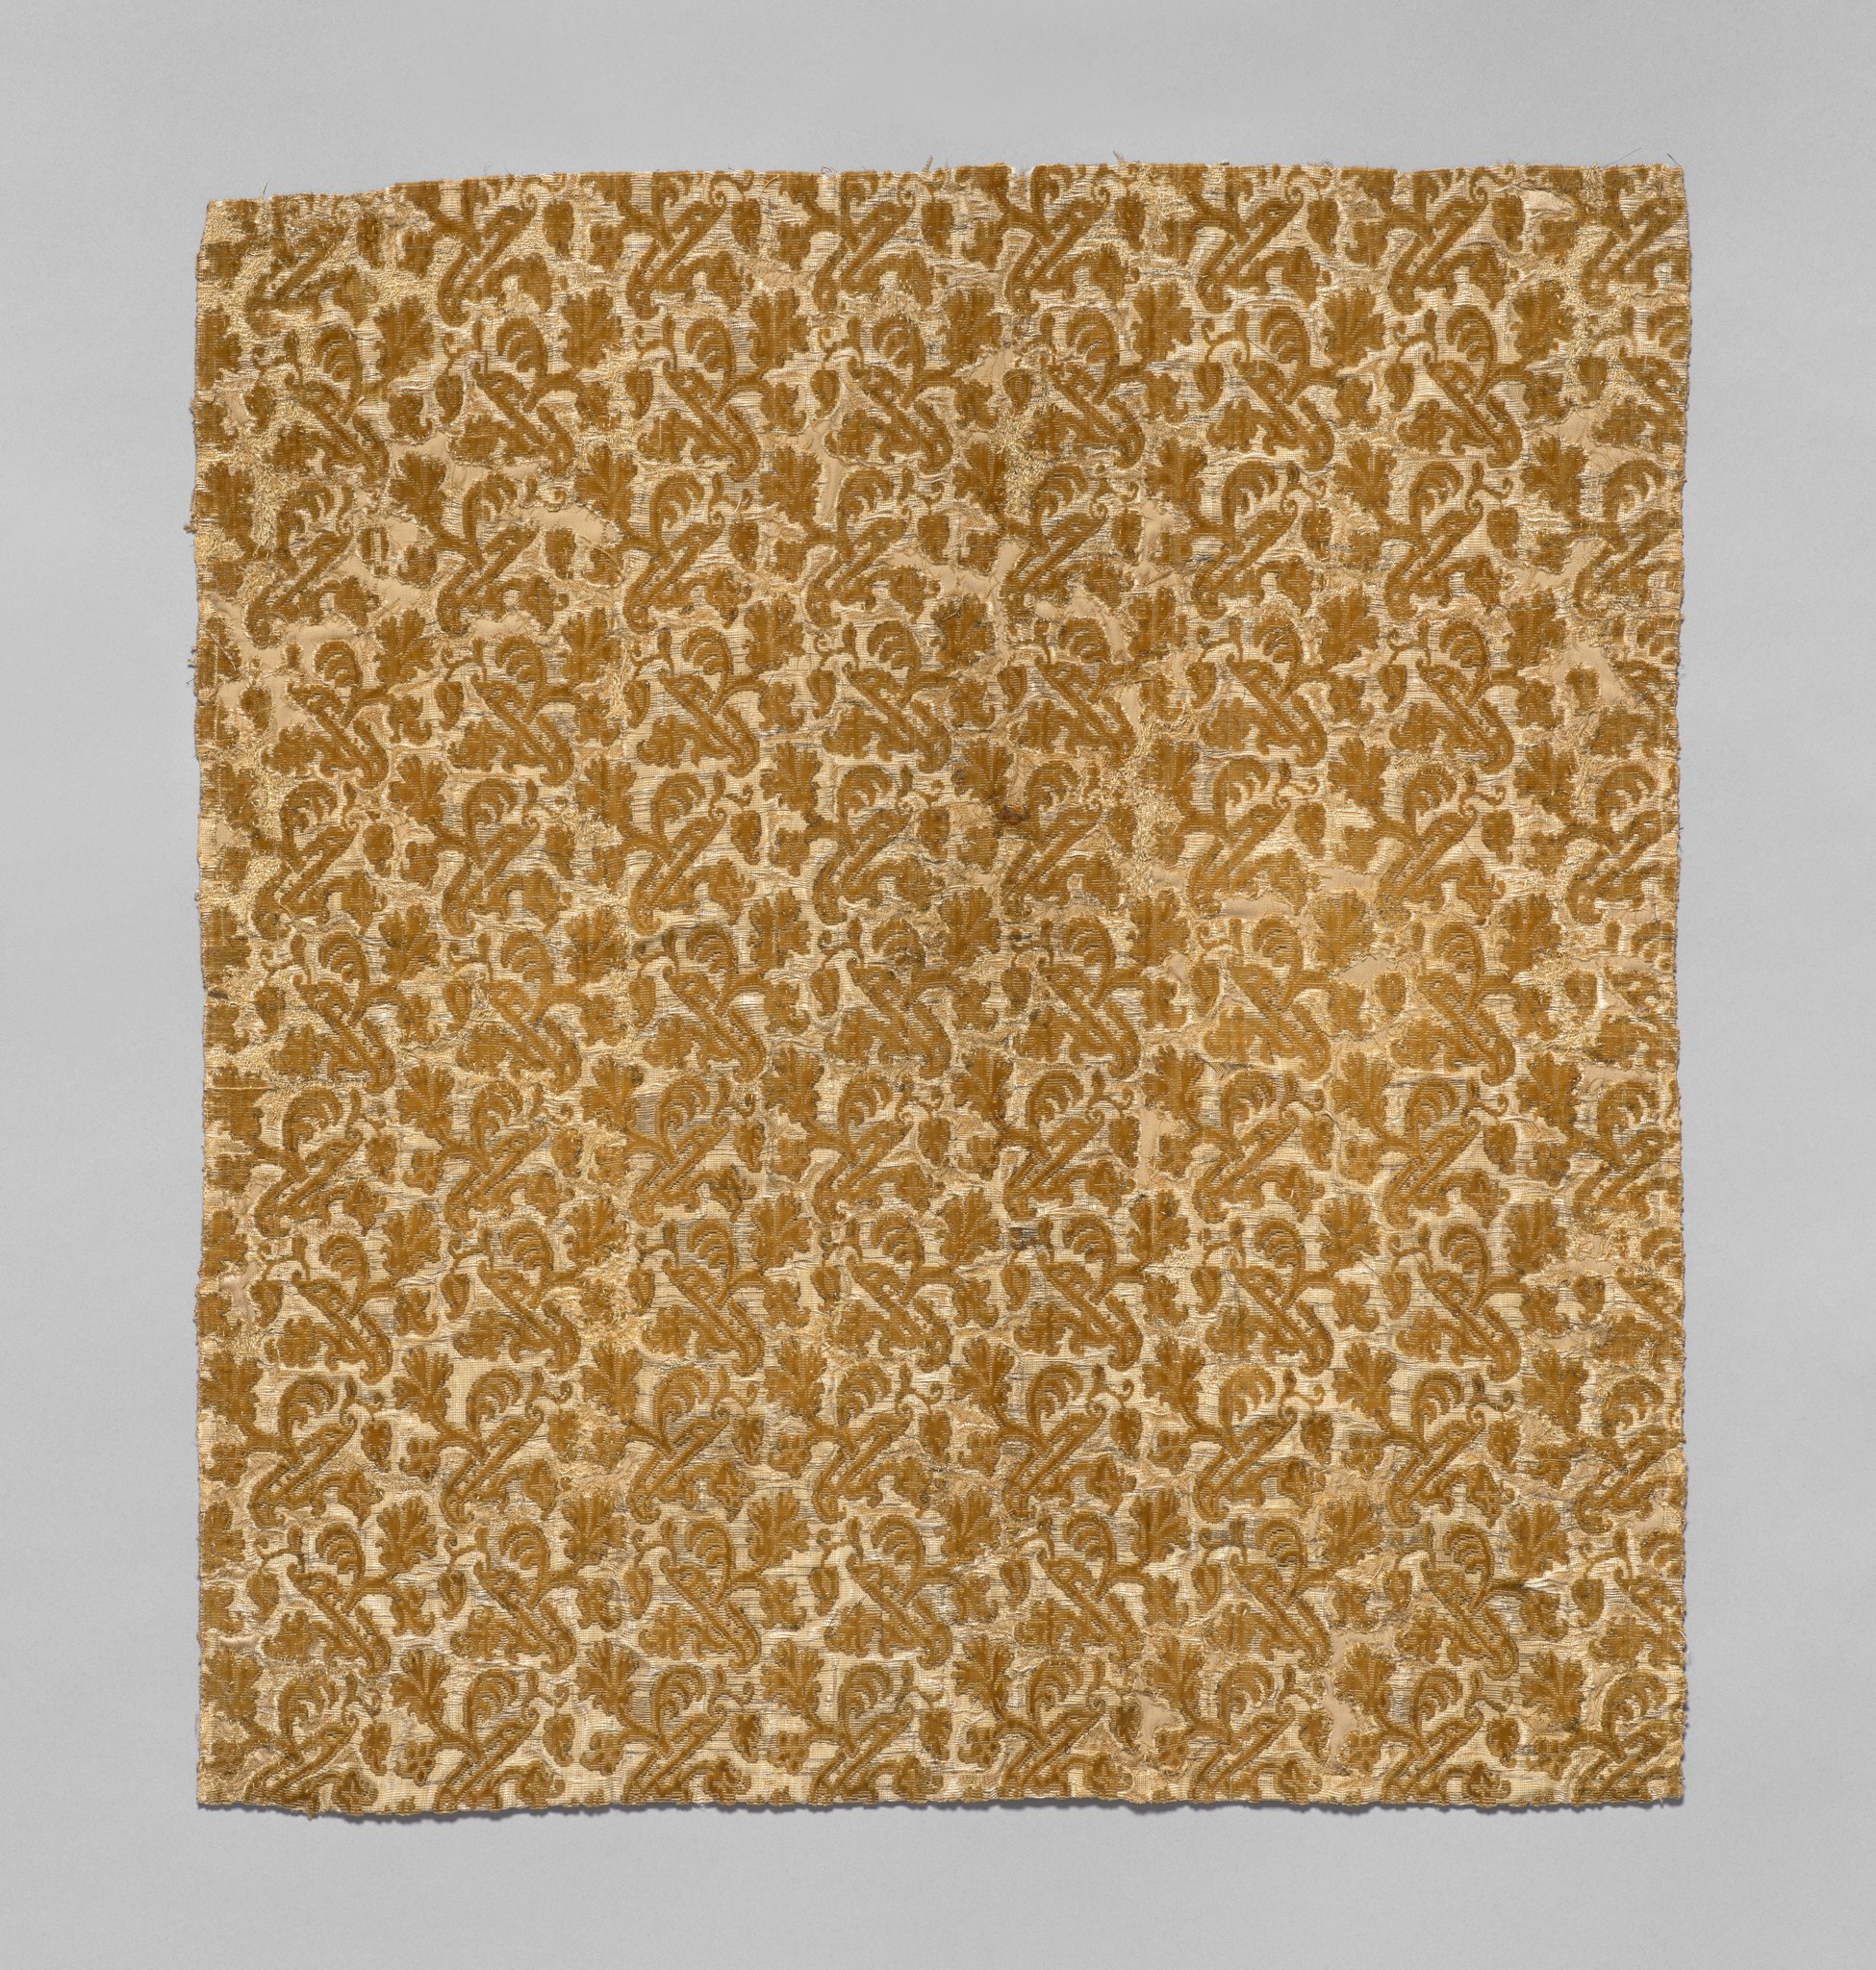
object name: piece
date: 1567-1600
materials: metal thread, silk